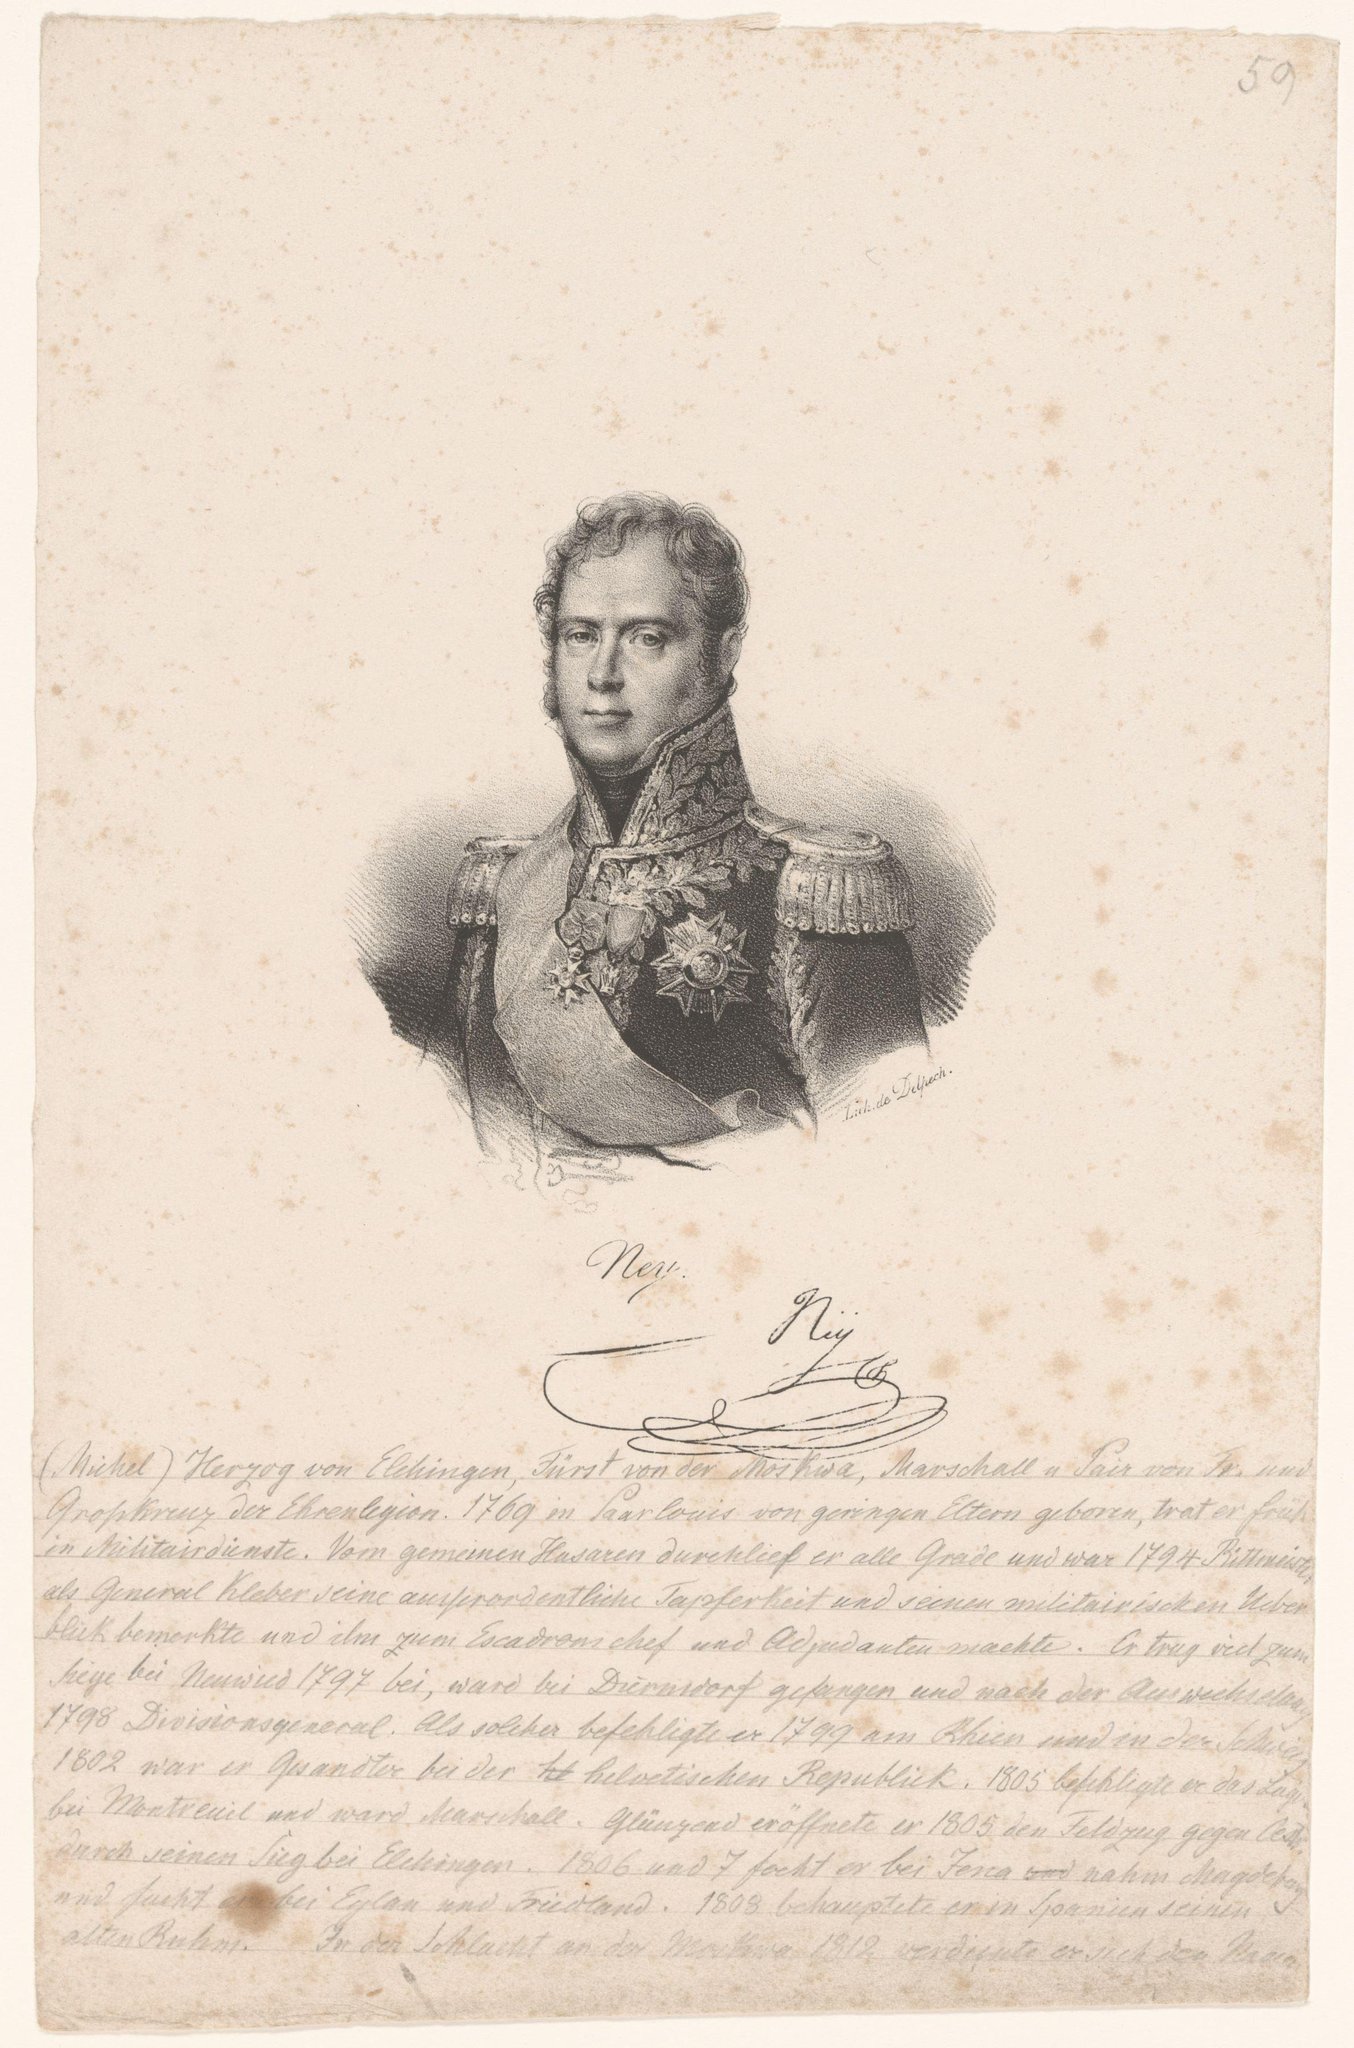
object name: print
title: Portret van Michel Ney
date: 1818-1842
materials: paper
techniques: lithograph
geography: paris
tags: paris, historical persons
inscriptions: collector's mark: Lugt 2228a